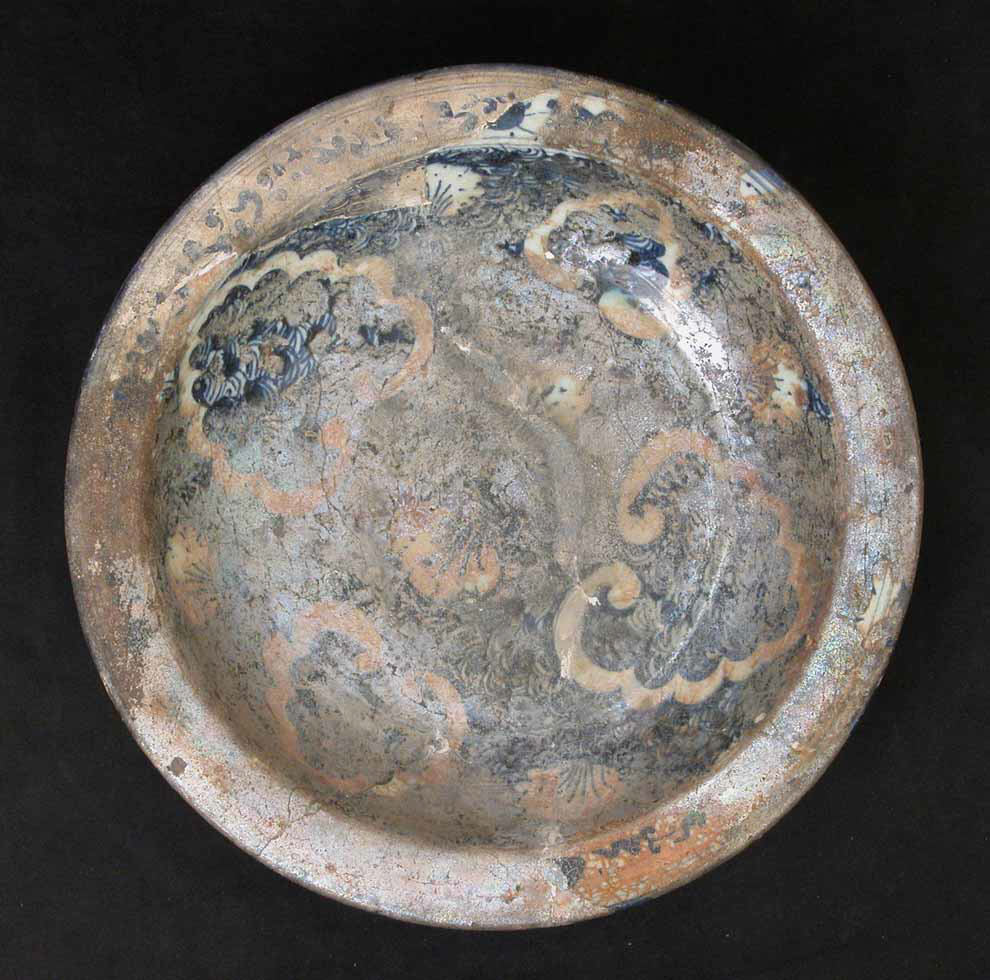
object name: bowl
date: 1367-1433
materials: stonepaste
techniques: glazing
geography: syria